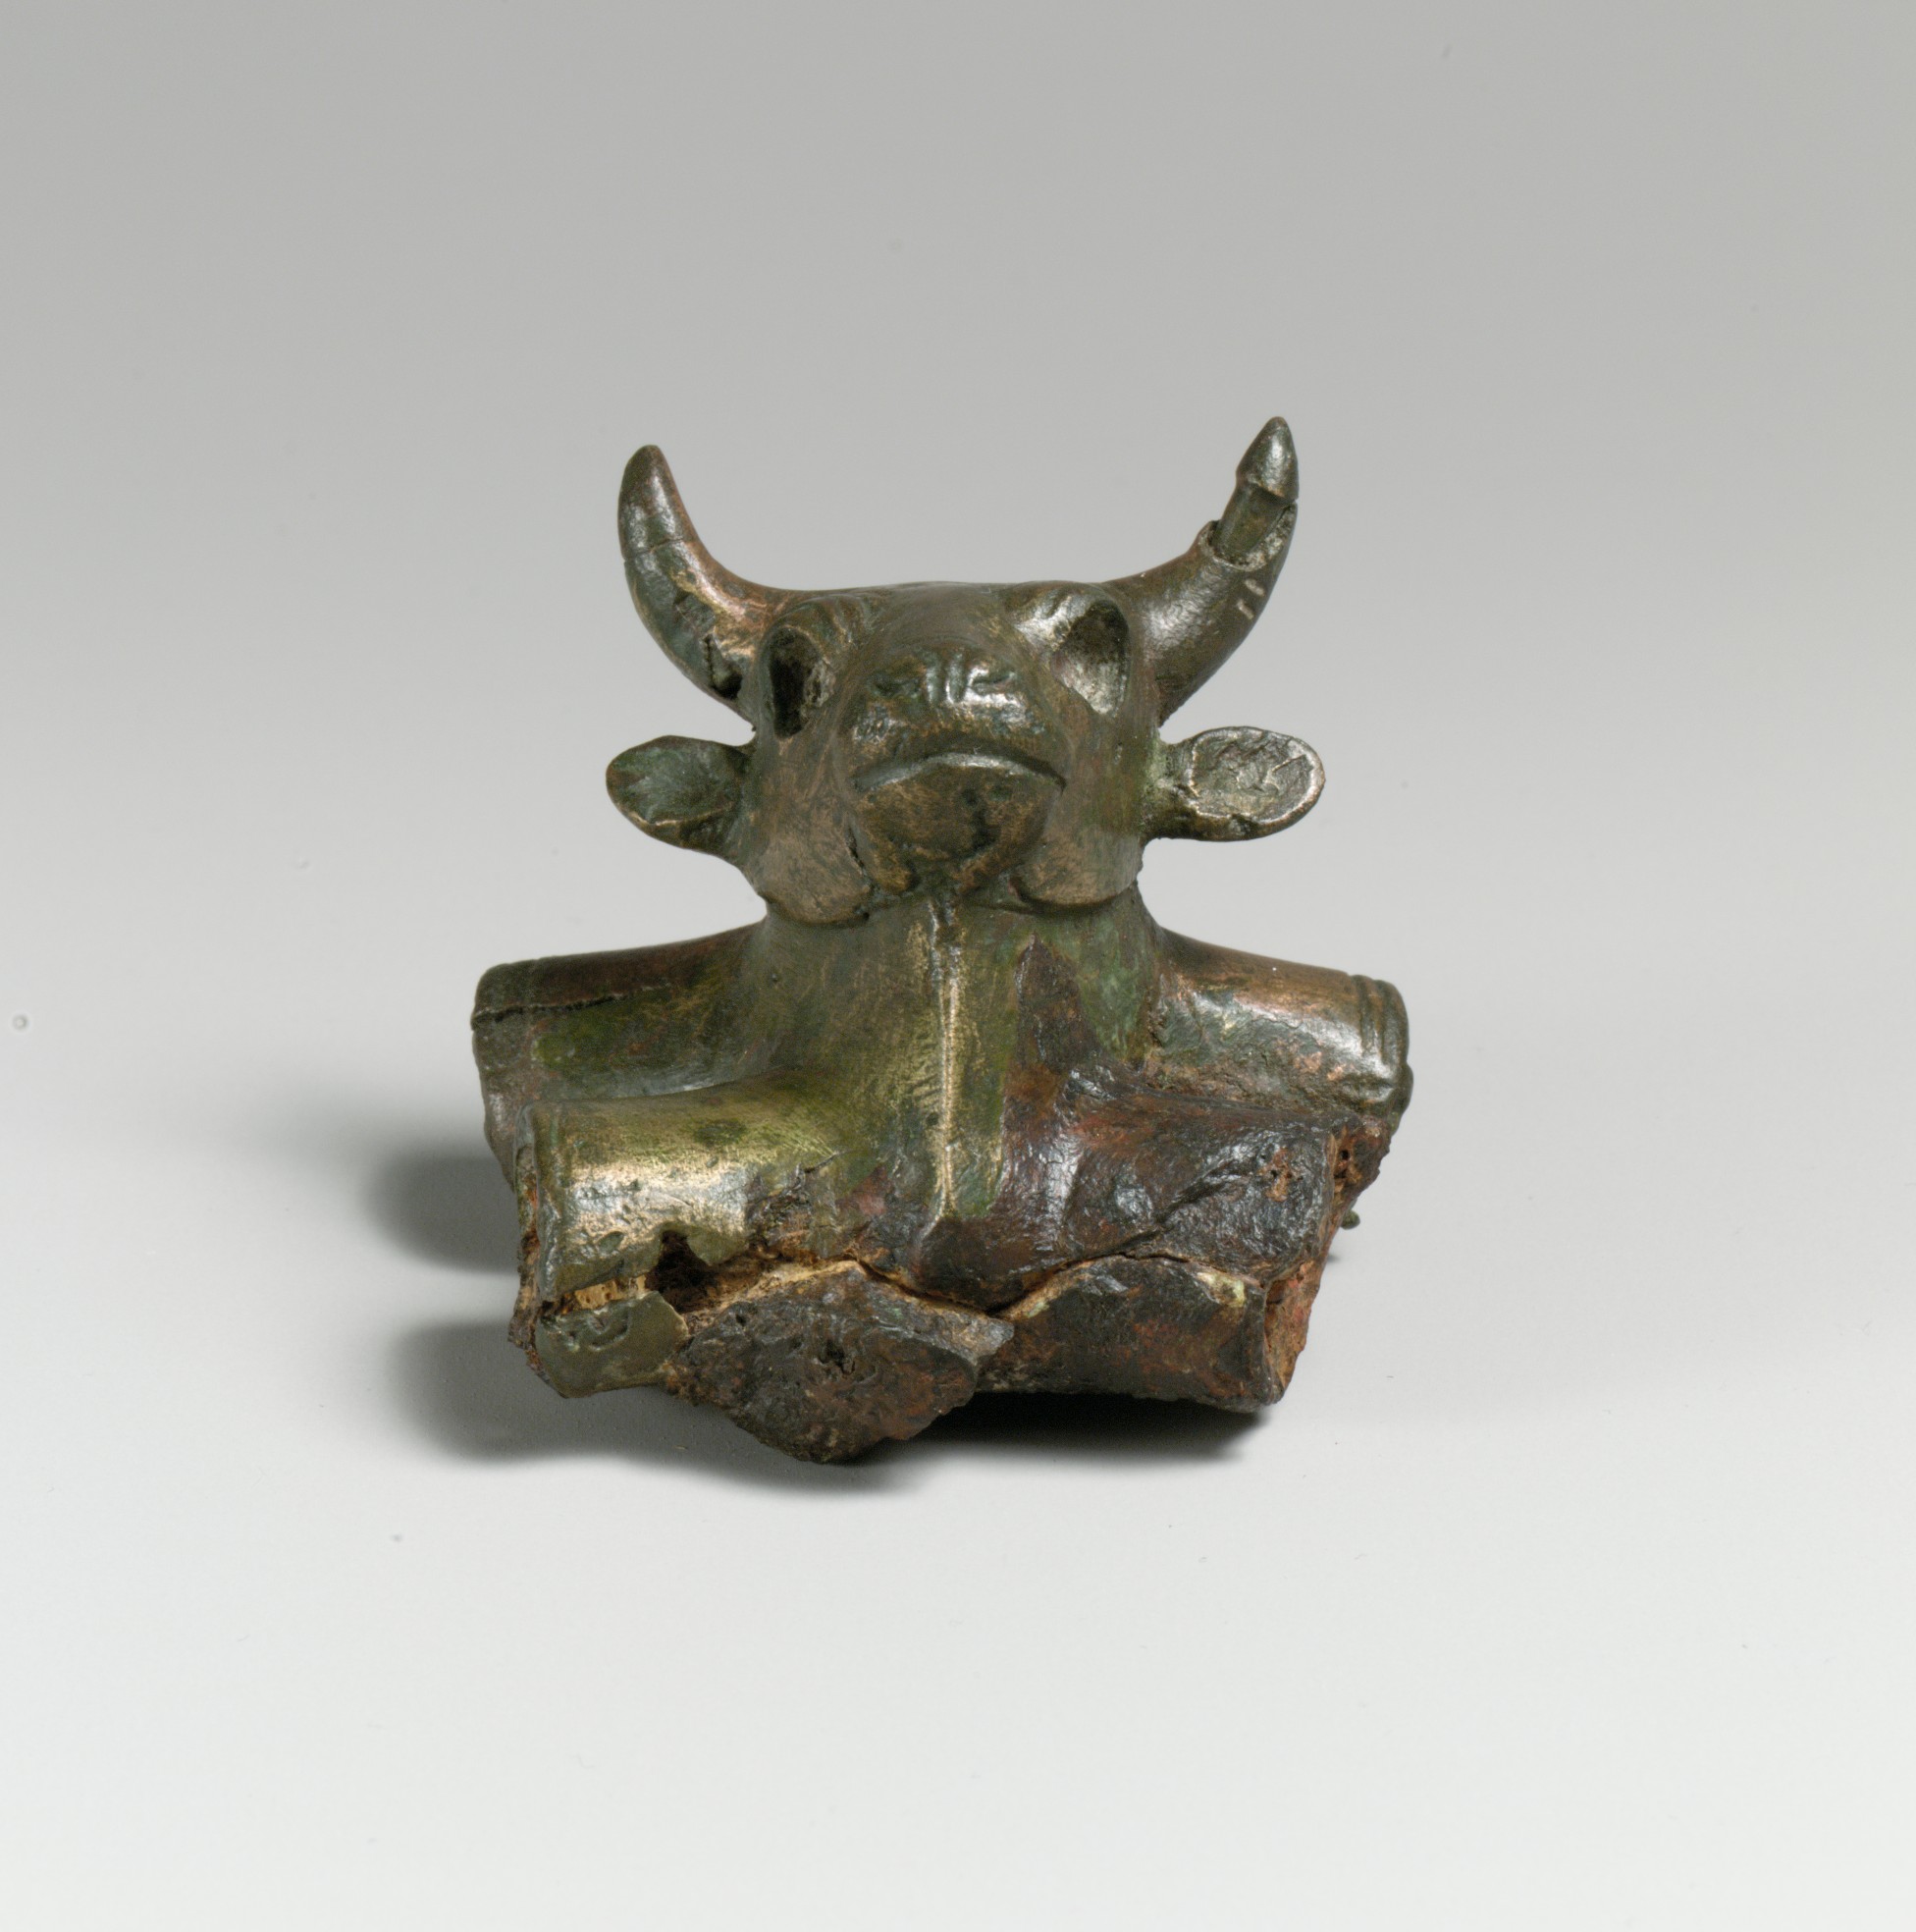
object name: attachment in the form of a bull's head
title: Bronze bull's head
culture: cypriot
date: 700-668 BCE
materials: bronze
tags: bulls